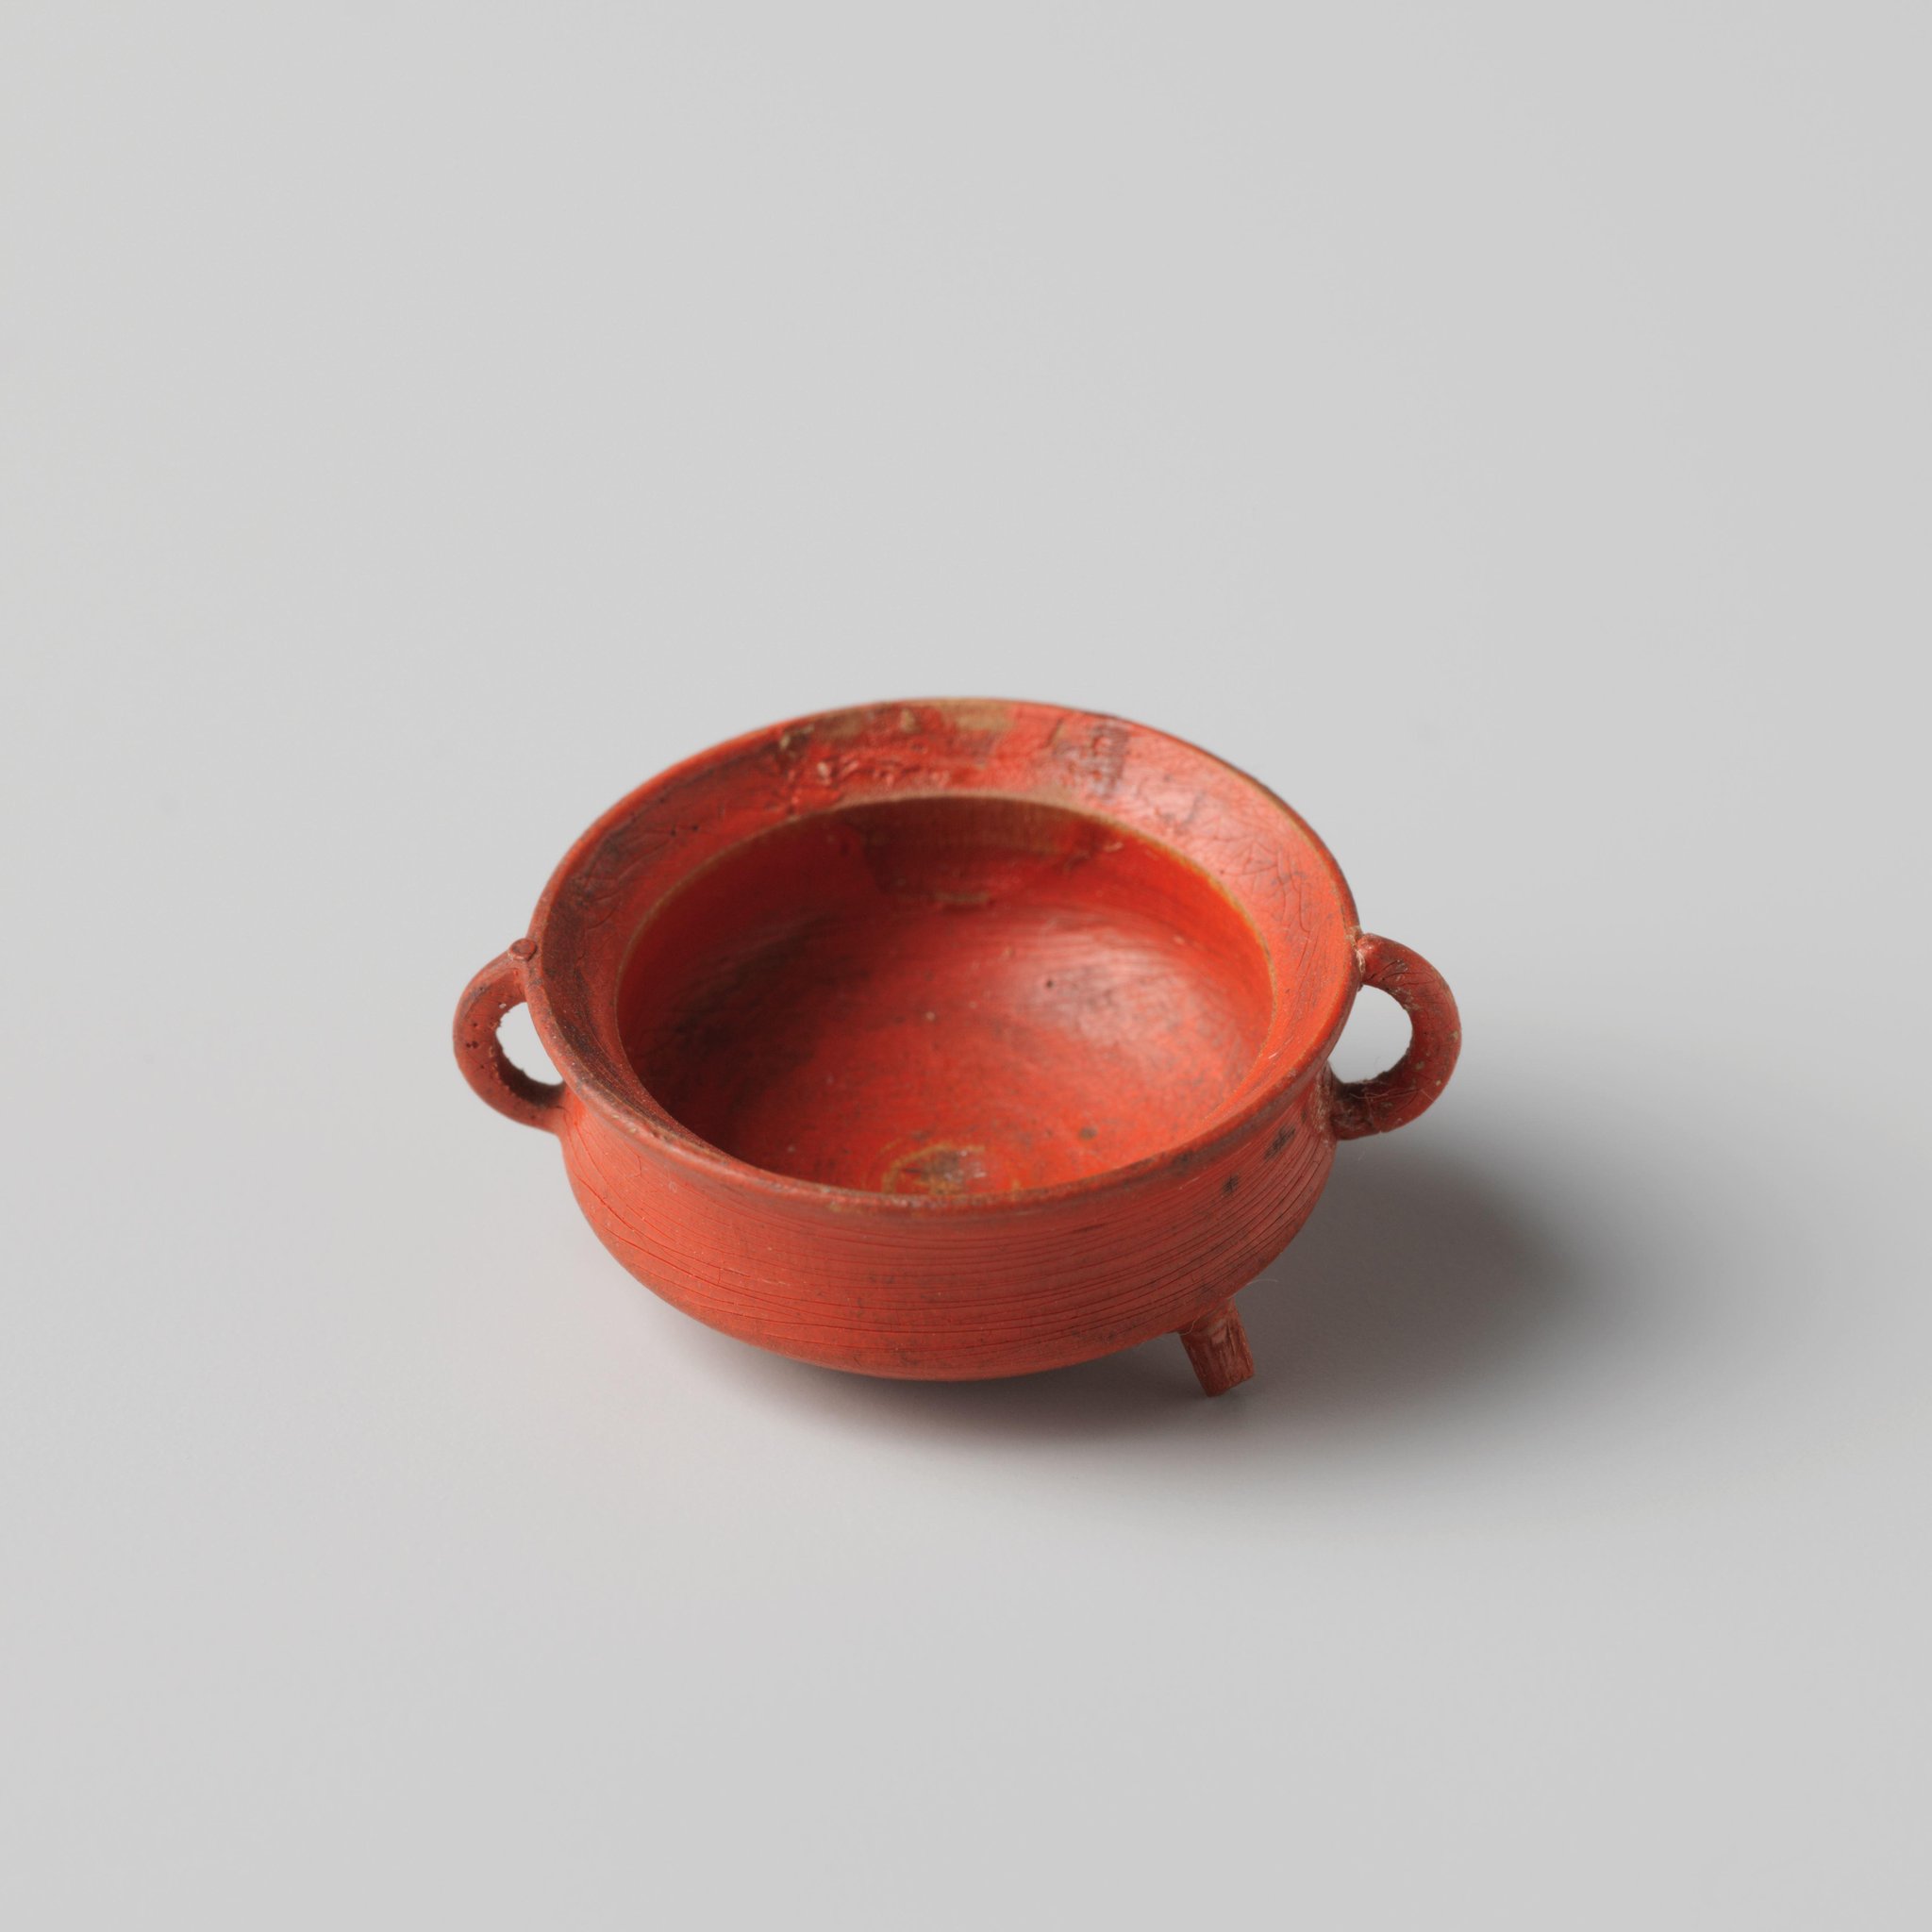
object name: miniature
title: Kookpot met twee oren op drie poten, roodgeverfd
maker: Anonymous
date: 1675-1700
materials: wood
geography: amsterdam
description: Kookpot met twee oren op drie poten (één mist) fijn gedraaid van esdoornhout (?) roodgeverfd.